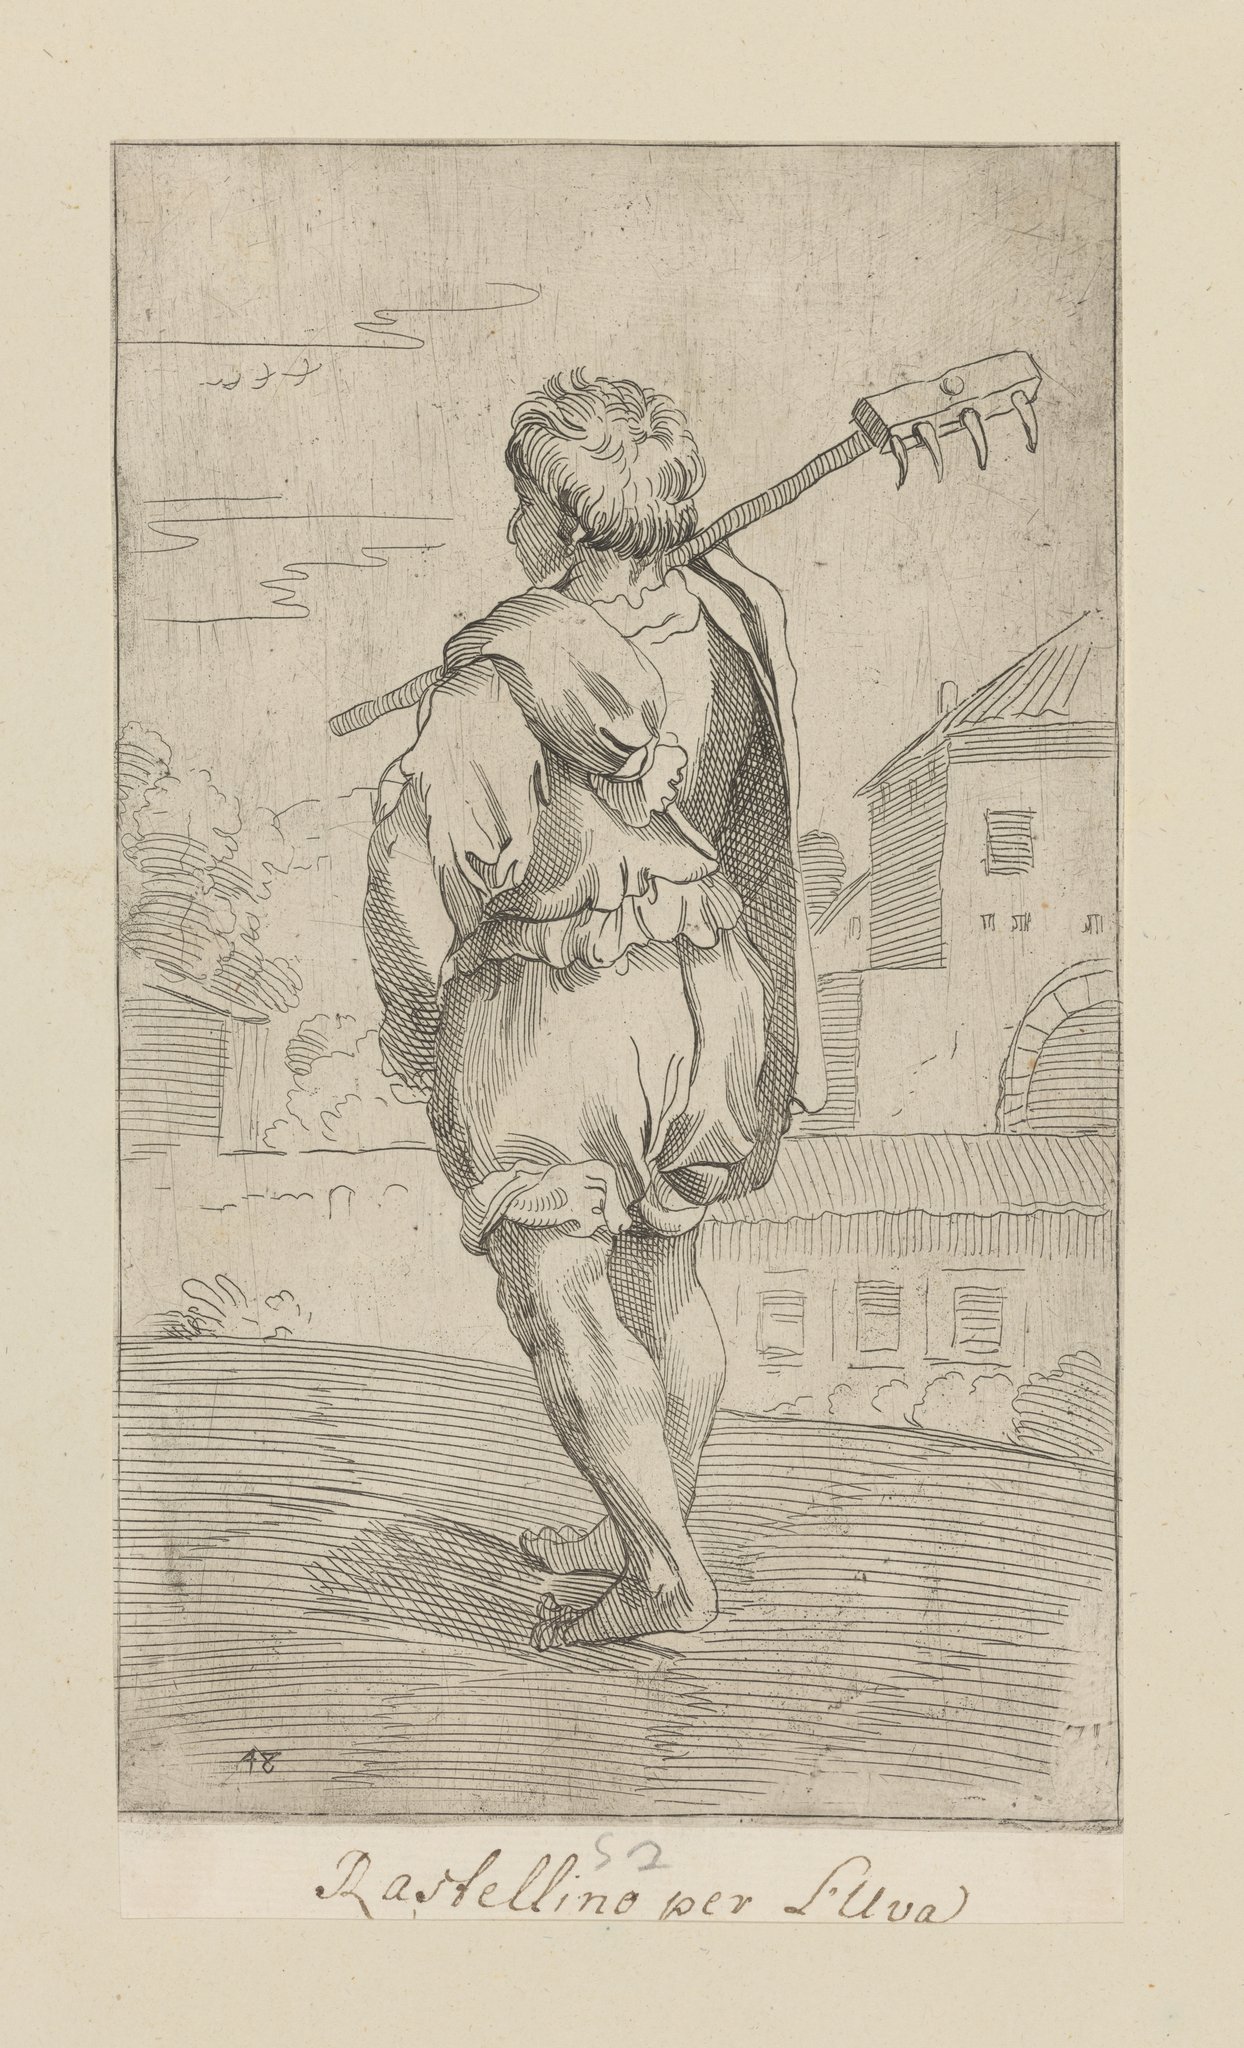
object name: print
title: Plate 48: Vineyard raker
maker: simon guillain ii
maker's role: artist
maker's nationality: french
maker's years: 1618-1718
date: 1646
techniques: etching